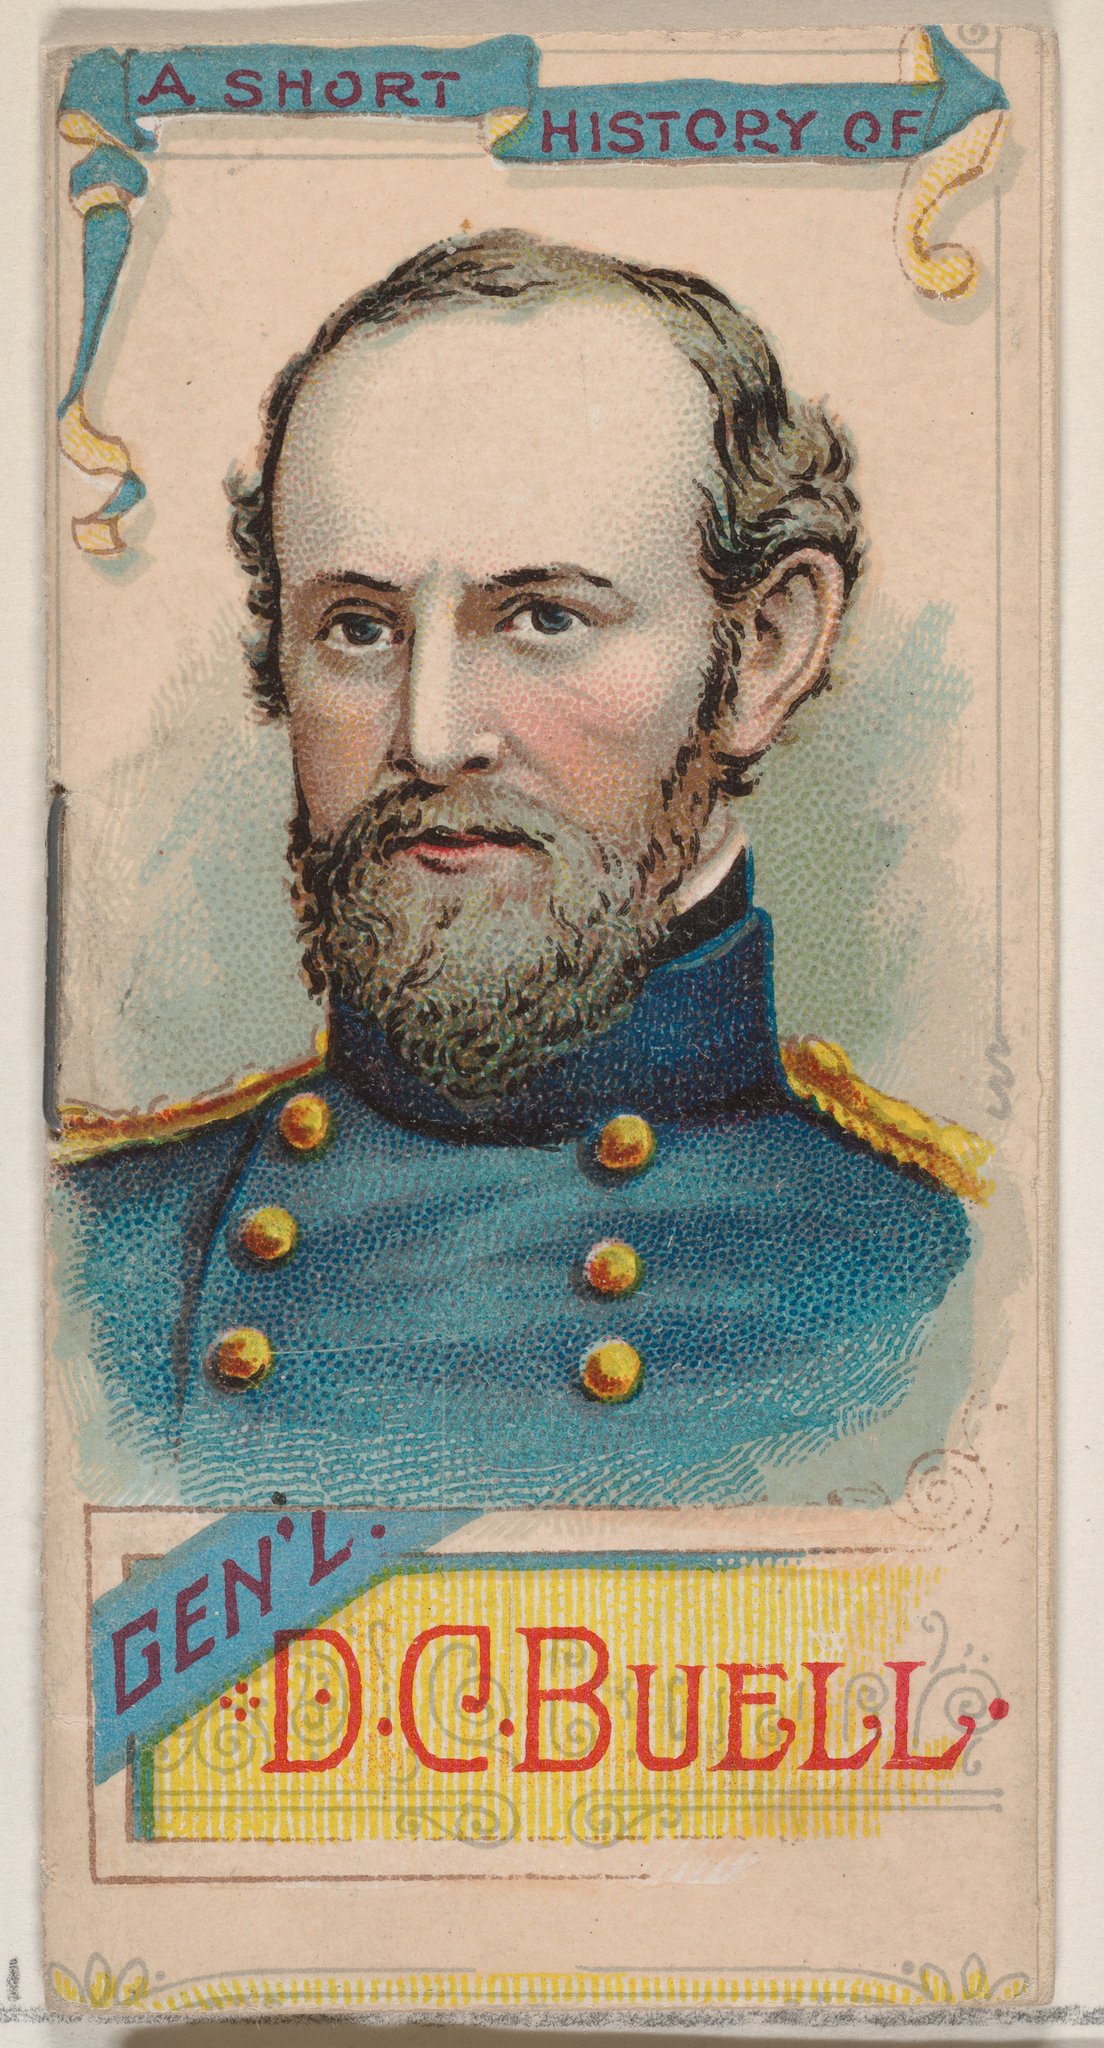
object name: print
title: A Short History of General Don Carlos Buell, from the Histories of Generals series of booklets (N78) for Duke brand cigarettes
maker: w. duke, sons & co.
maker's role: publisher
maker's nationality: american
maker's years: 1870-1920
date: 1888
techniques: color lithograph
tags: men,portraits